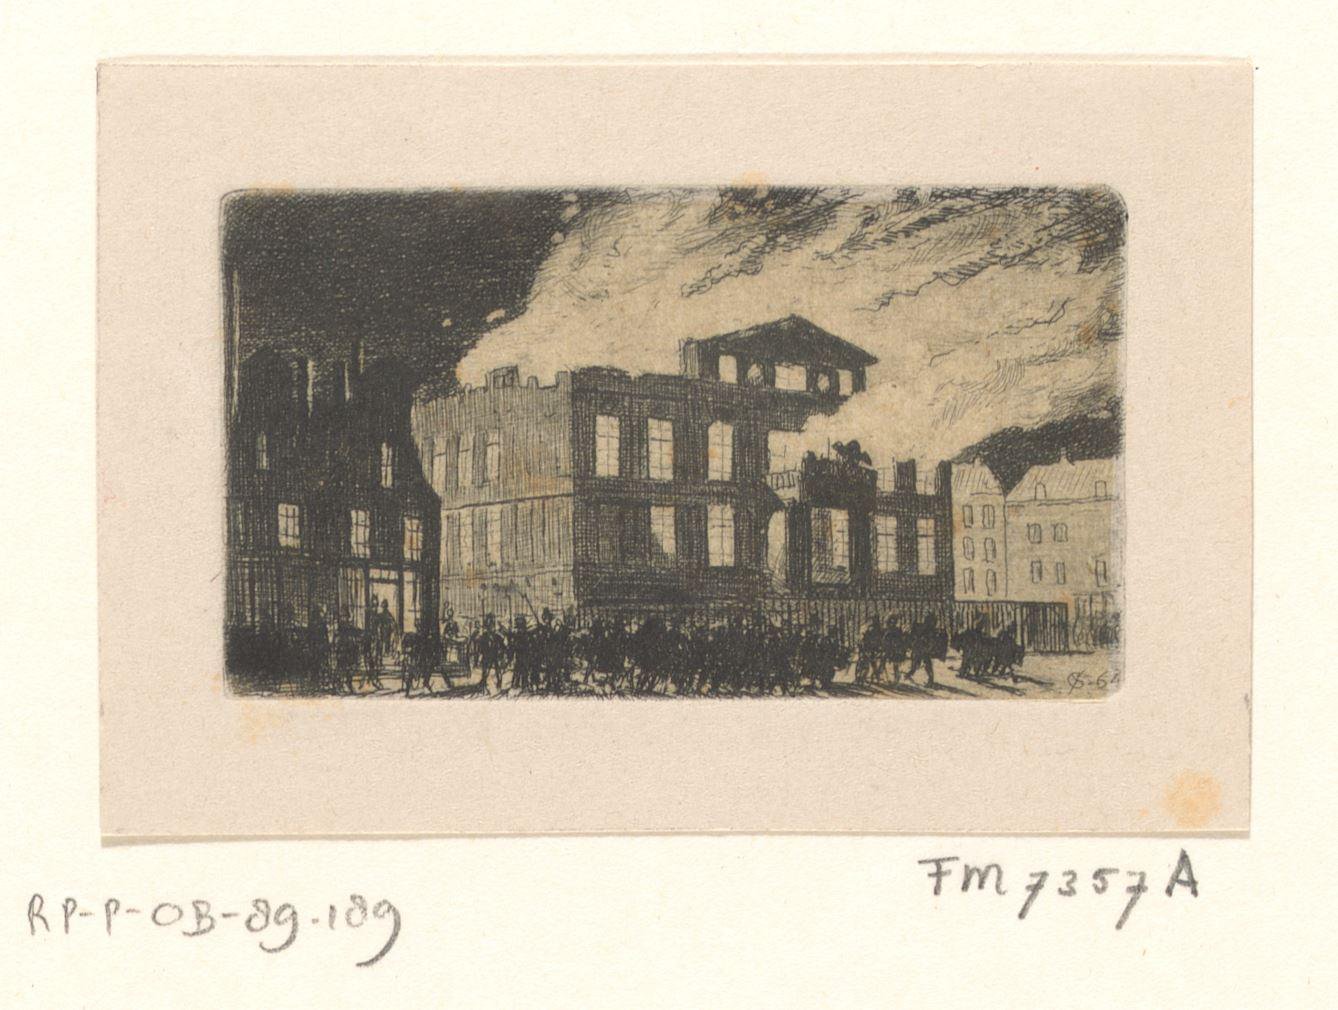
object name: print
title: Brand in het Museum Boijmans te Rotterdam, 1864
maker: cornelis van der griendt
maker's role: draughtsman, painter, print maker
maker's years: 1827-1918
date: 1864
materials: paper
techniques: etching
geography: netherlands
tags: on fire, ablaze, permanent exhibition, museum, rotterdam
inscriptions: collector's mark: Lugt 2228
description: Brand in het Museum Boijmans in het Schielandshuis te Rotterdam, 16 februari 1864.